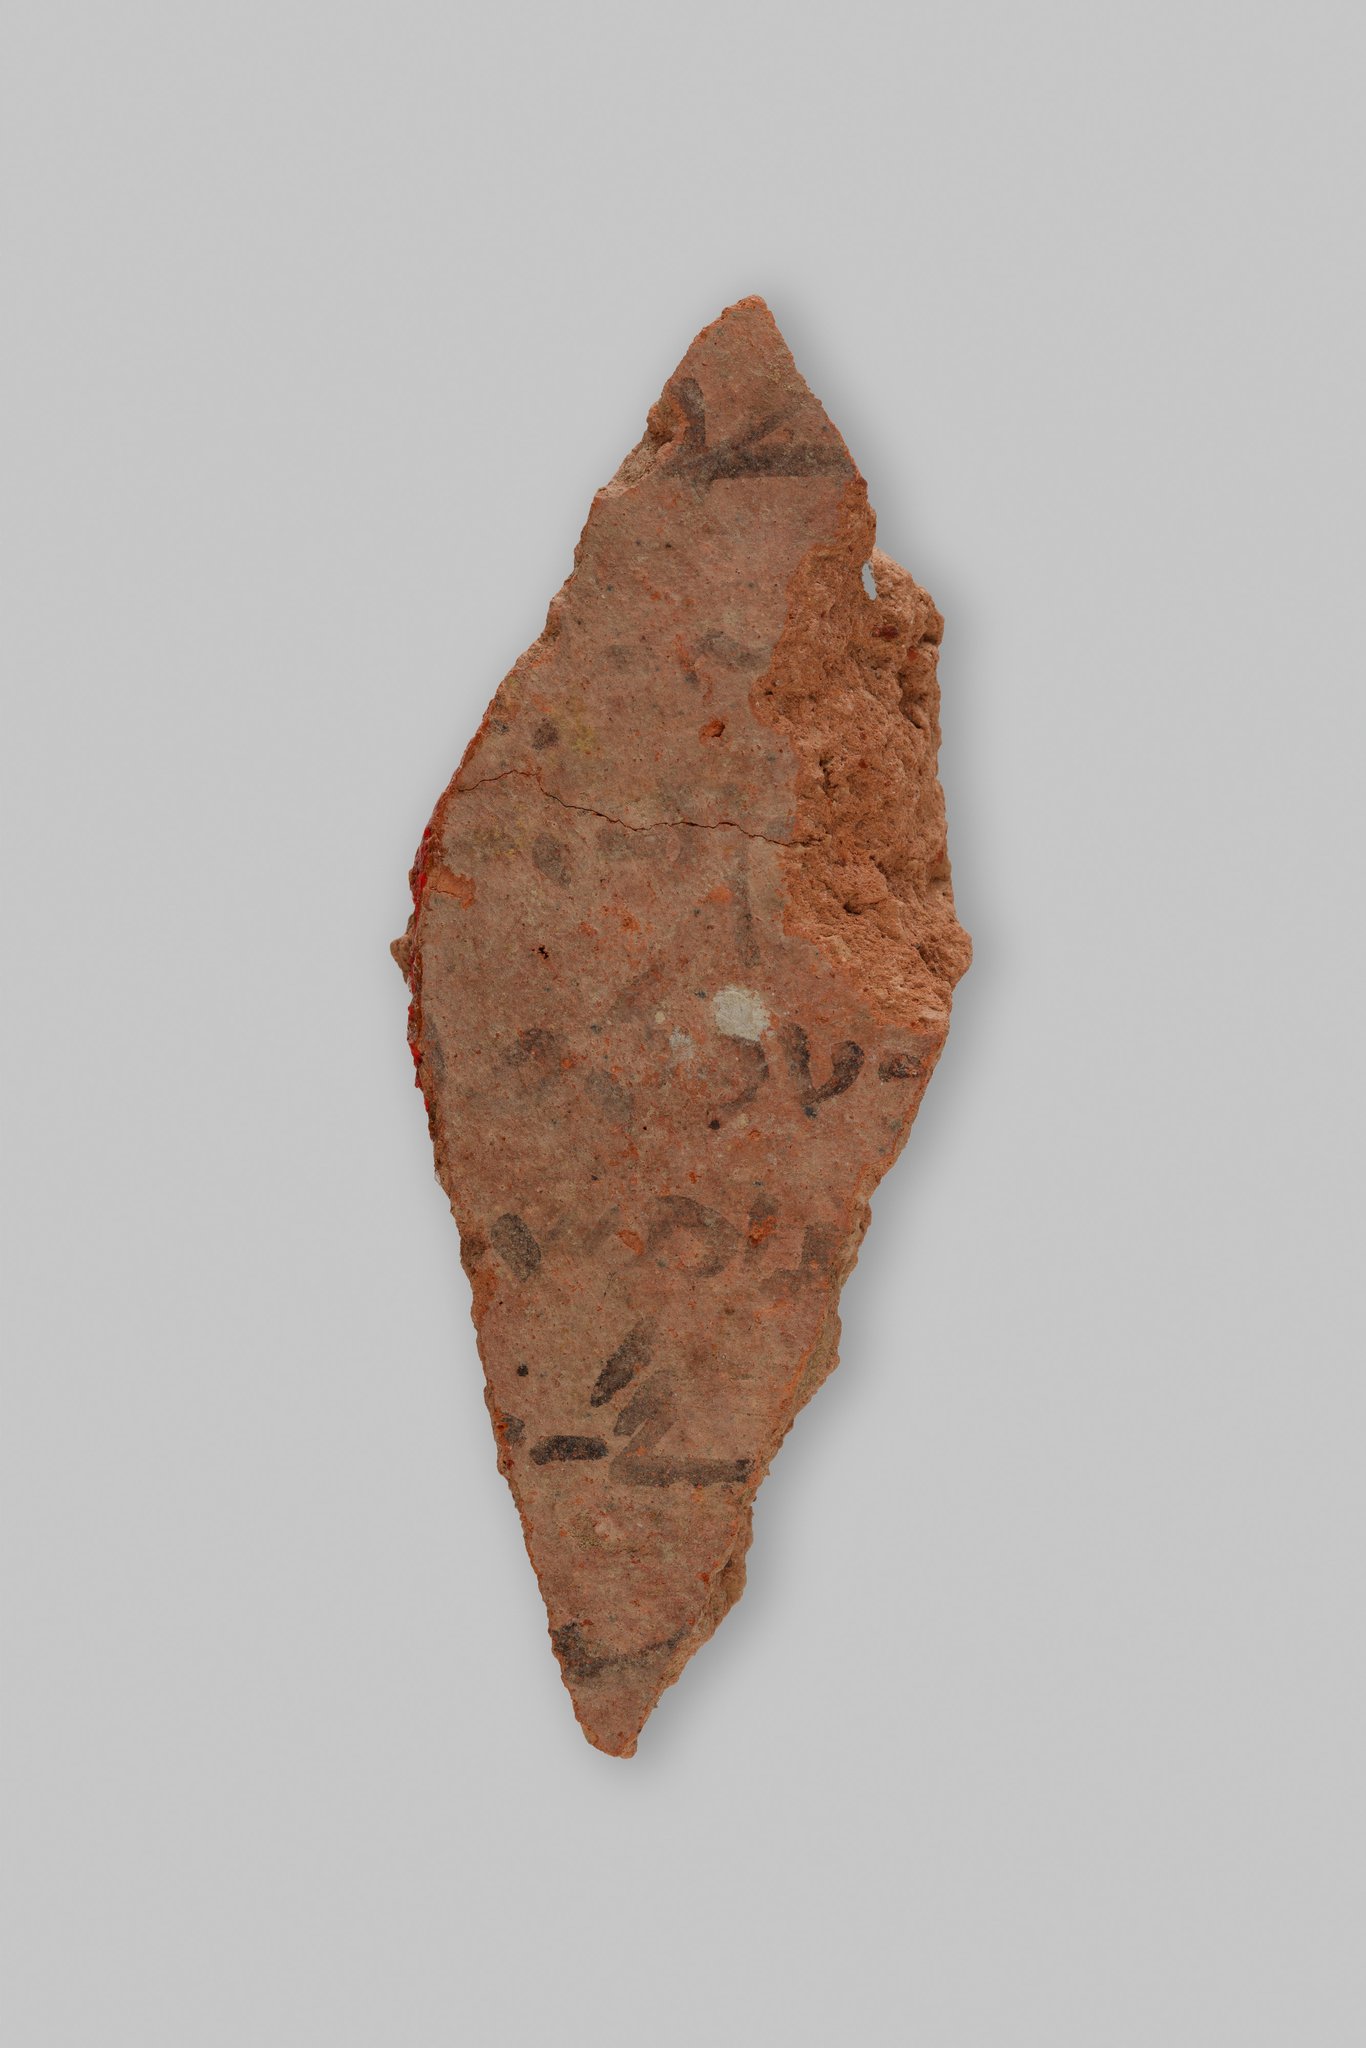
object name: ostracon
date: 400-30 BCE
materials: ink, pottery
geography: egypt